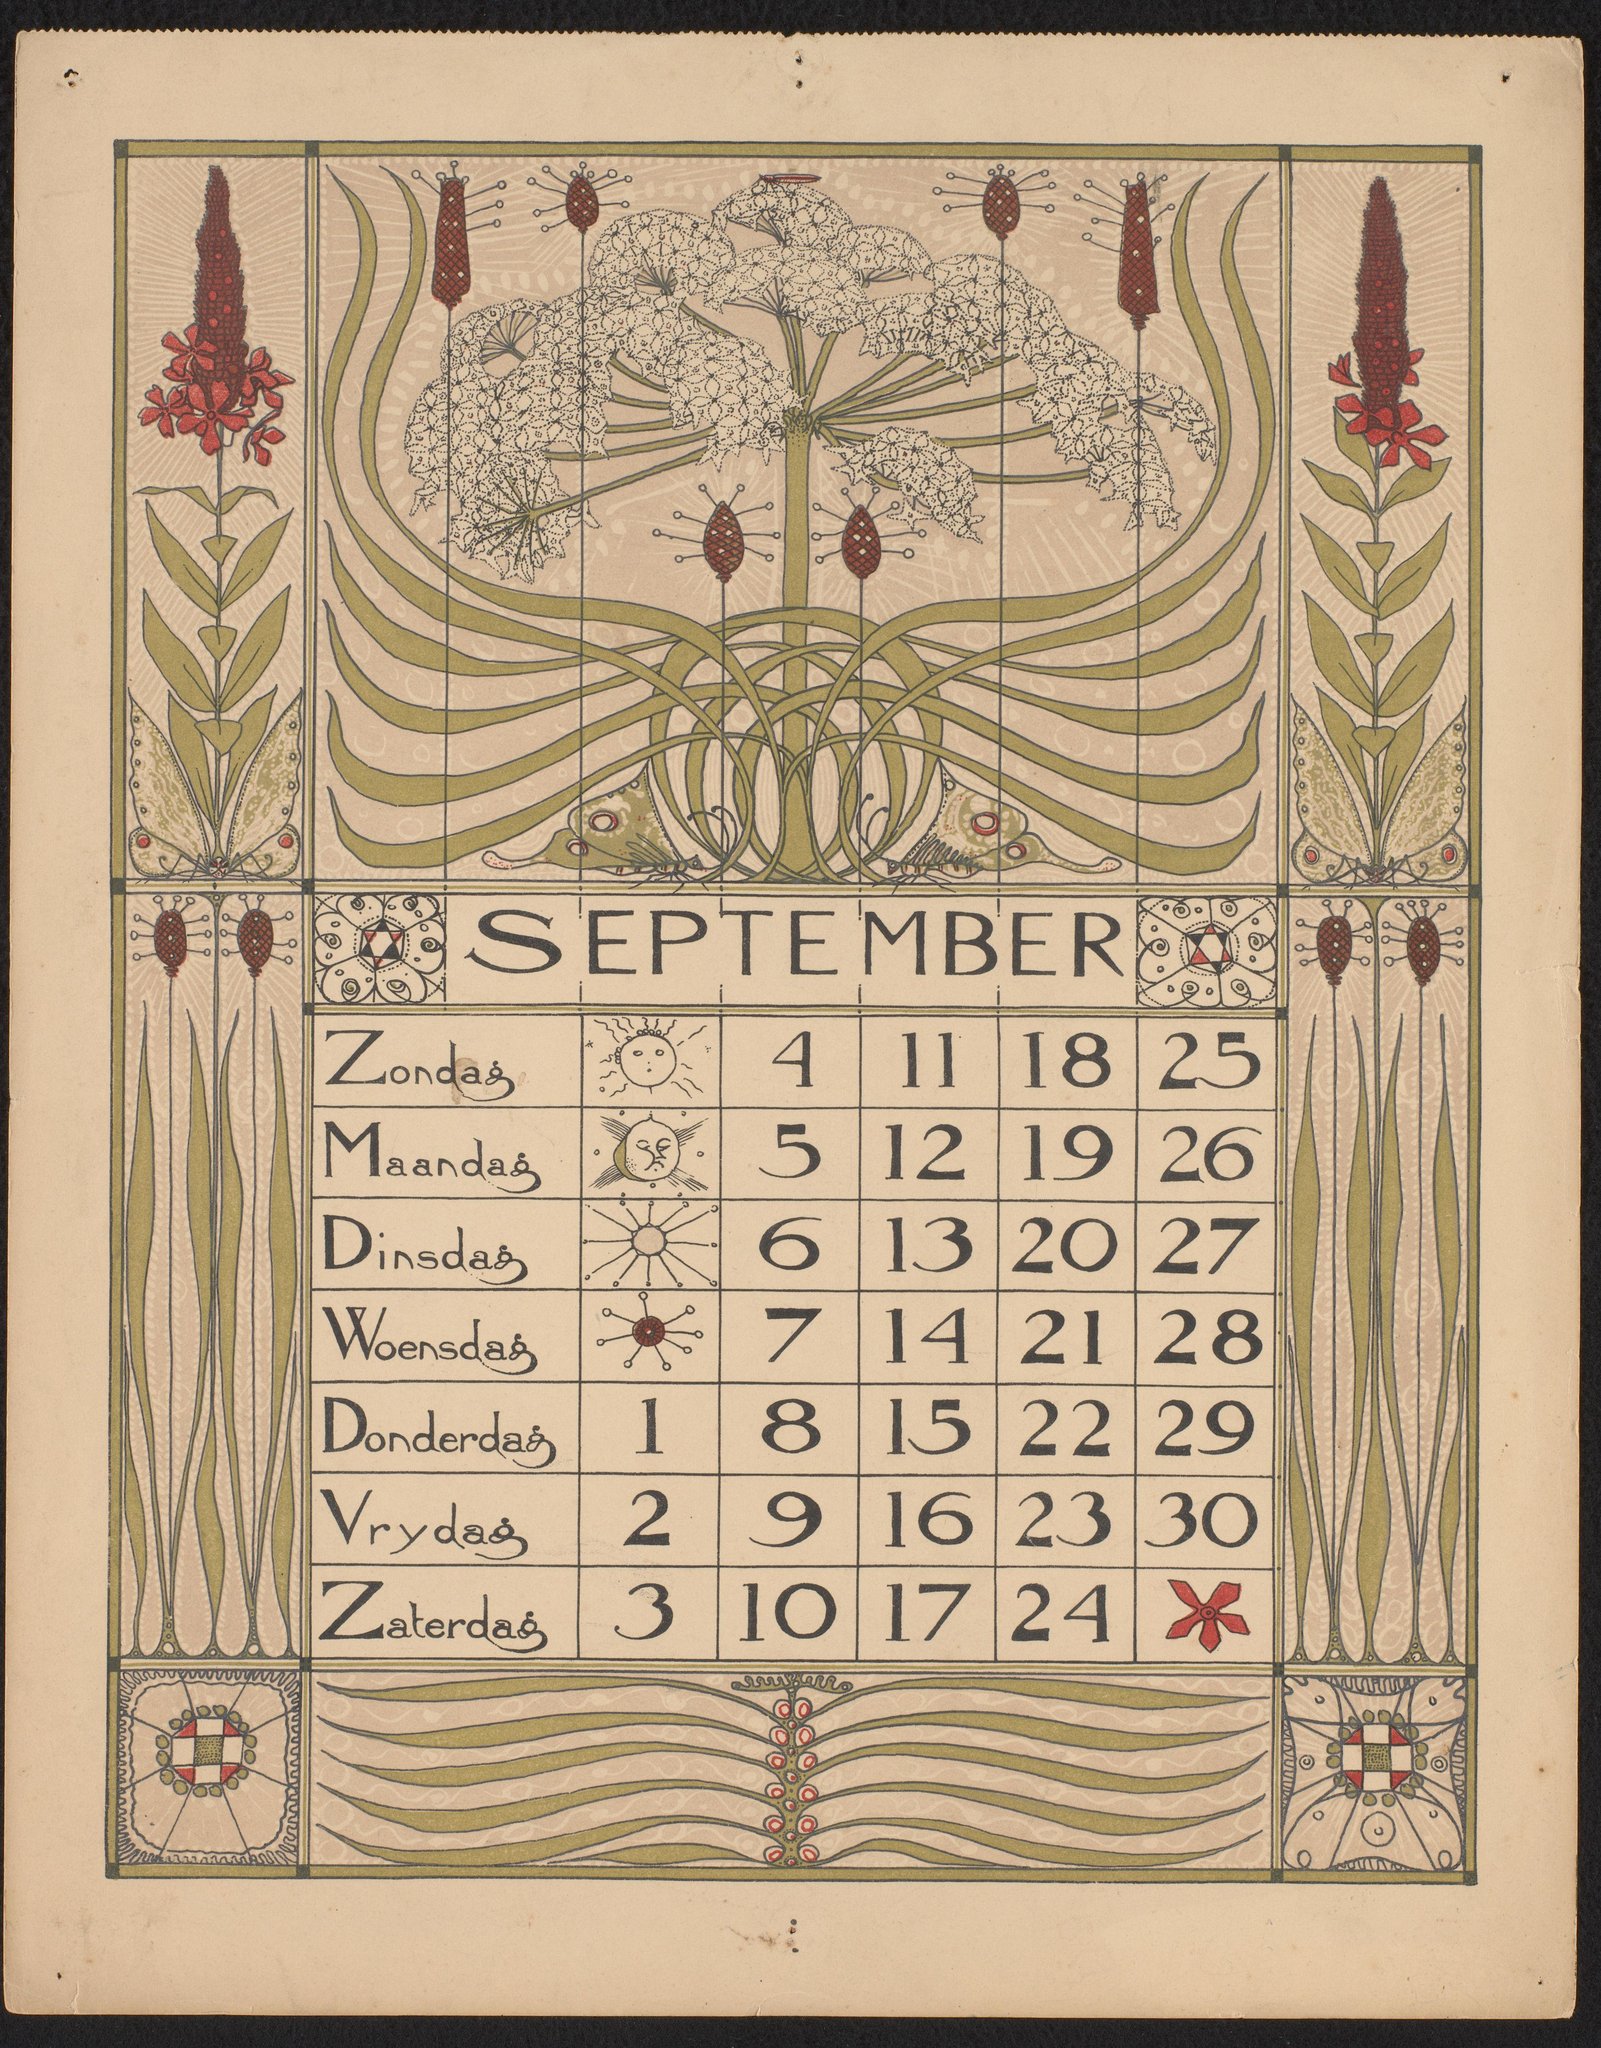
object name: calendar leaf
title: Kalenderblad voor september 1898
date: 1897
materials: paper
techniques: lithograph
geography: amsterdam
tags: trees, calendar, almanac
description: Randdecoratie van bloeiende en uitgebloeide schermbloemigen rond de maandkalender voor september. Bovenrand geperforeerd waar dit kalenderblad verbonden was met de rest van het jaar.